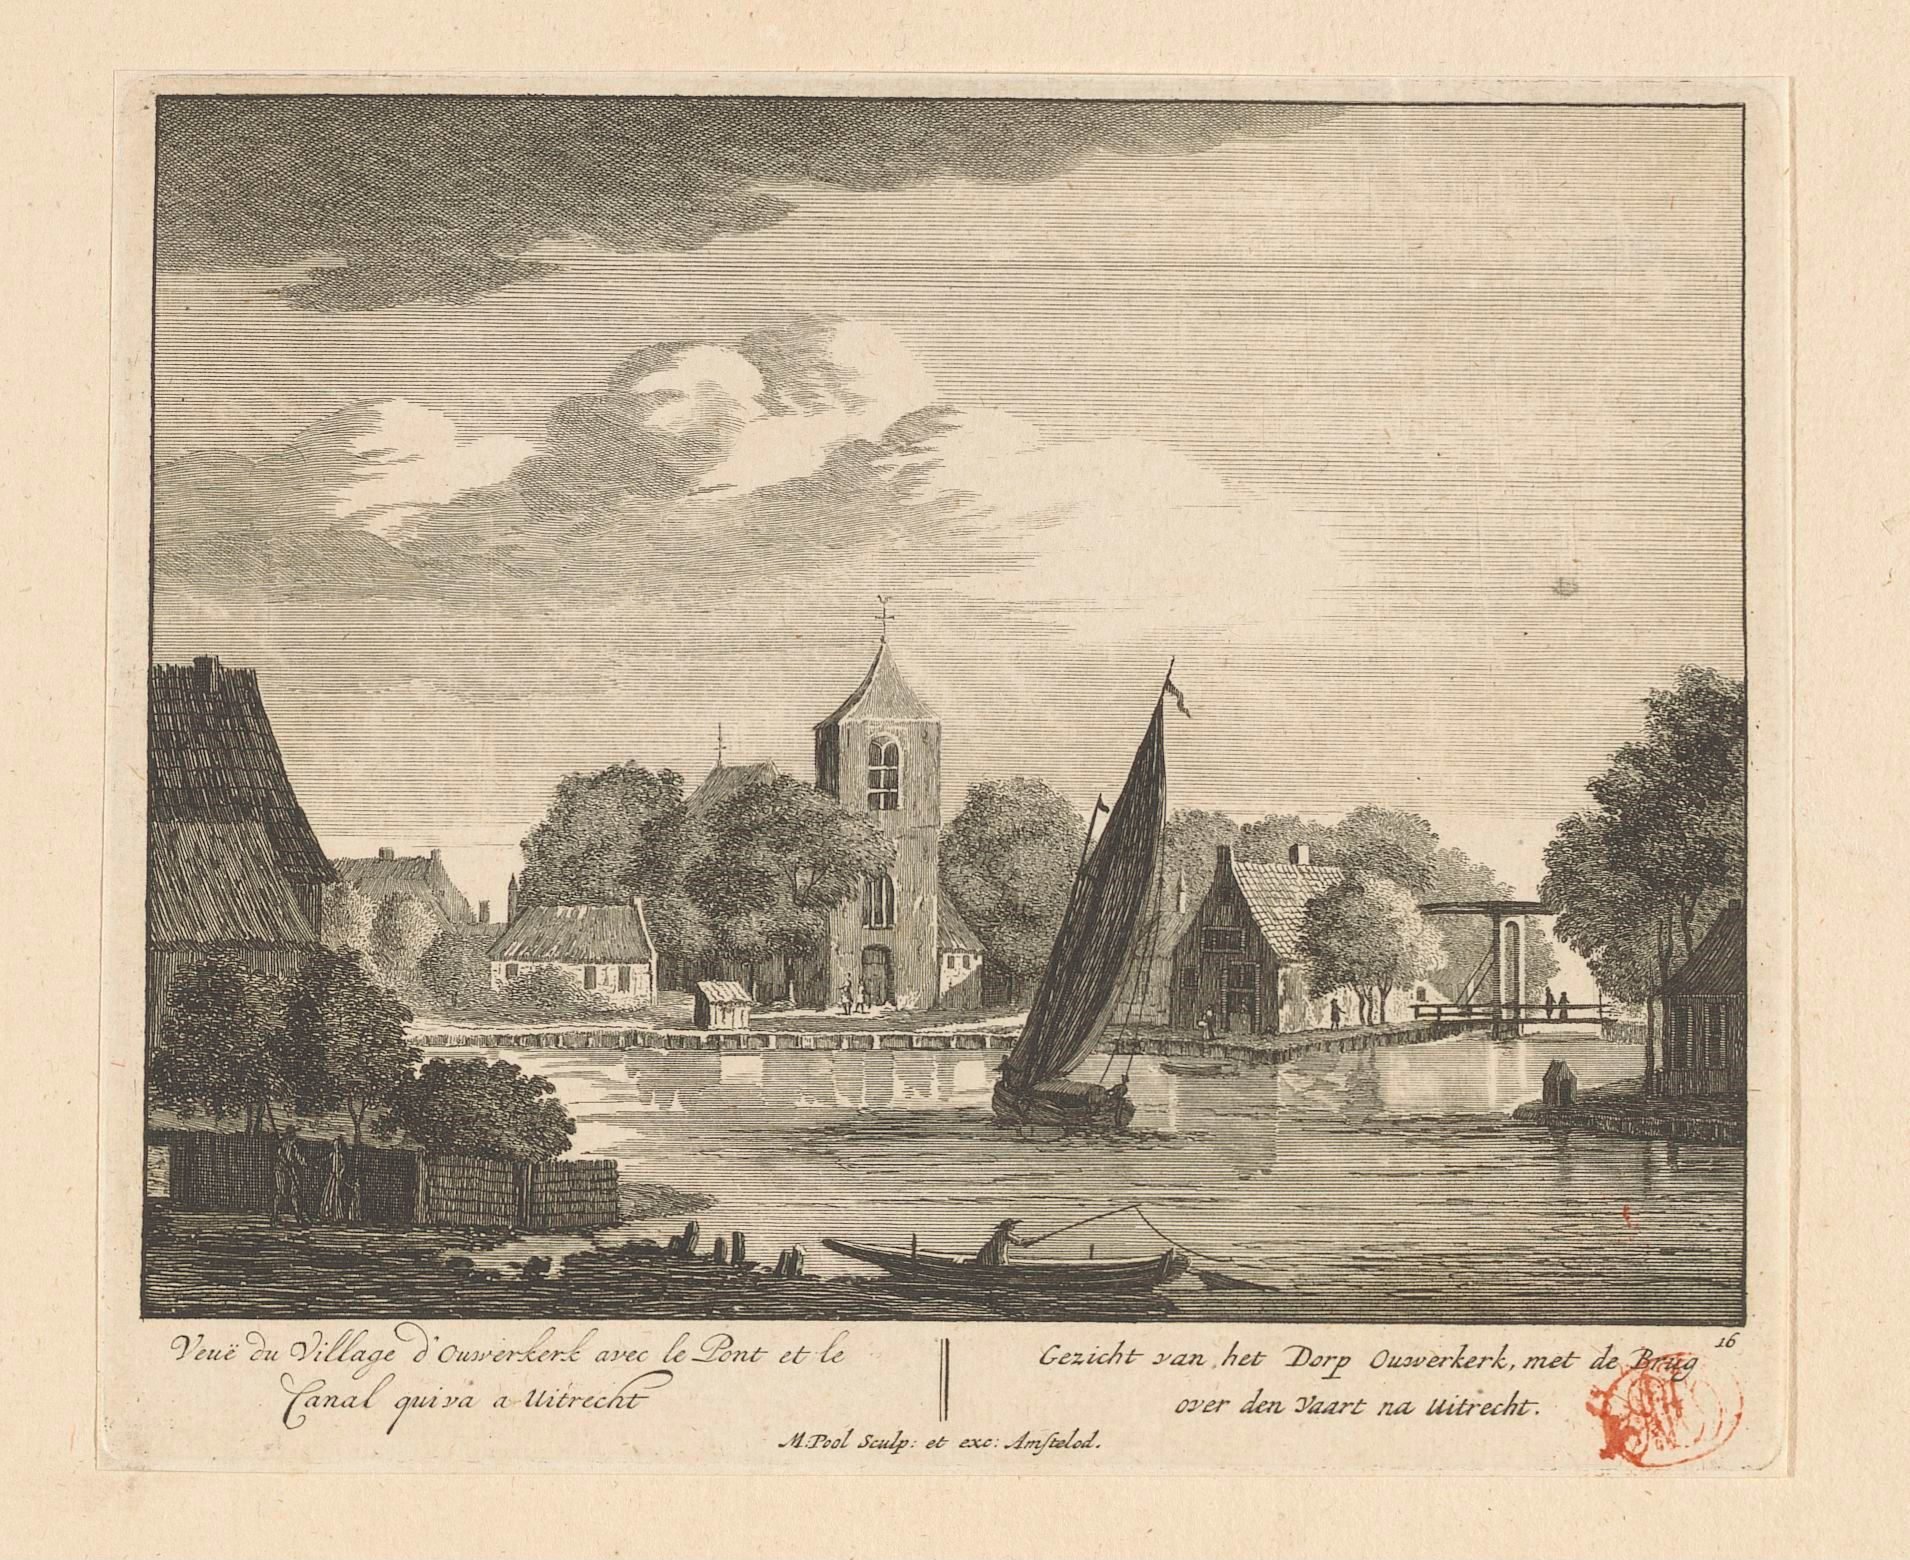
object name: print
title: Gezicht op de Amstel bij Ouderkerk aan de Amstel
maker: matthijs pool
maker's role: print maker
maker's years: 1676-1740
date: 1708-1740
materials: paper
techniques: engraving, etching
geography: amsterdam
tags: sailing-ship, sailing-boat, river, church (exterior), rowing-boat, canoe, etc., bridge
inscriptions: collector's mark: Lugt 195, collector's mark: Lugt 2233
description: Prent gebruikt in: Pool, Matthijs. Verscheyde gesigten van de vermaarde rievier de buyten Amstel van de stadt Amsterdam, tot het dorp Ouwerkerk (…) / Plusieurs veuës et perspectives de la fameuse riviére de Buyten-Amstel depuis Amsterdam jusqu'au village d'Ouwerkerk (…). Amsterdam: Matthijs Pool, z.j. [1708-1740].